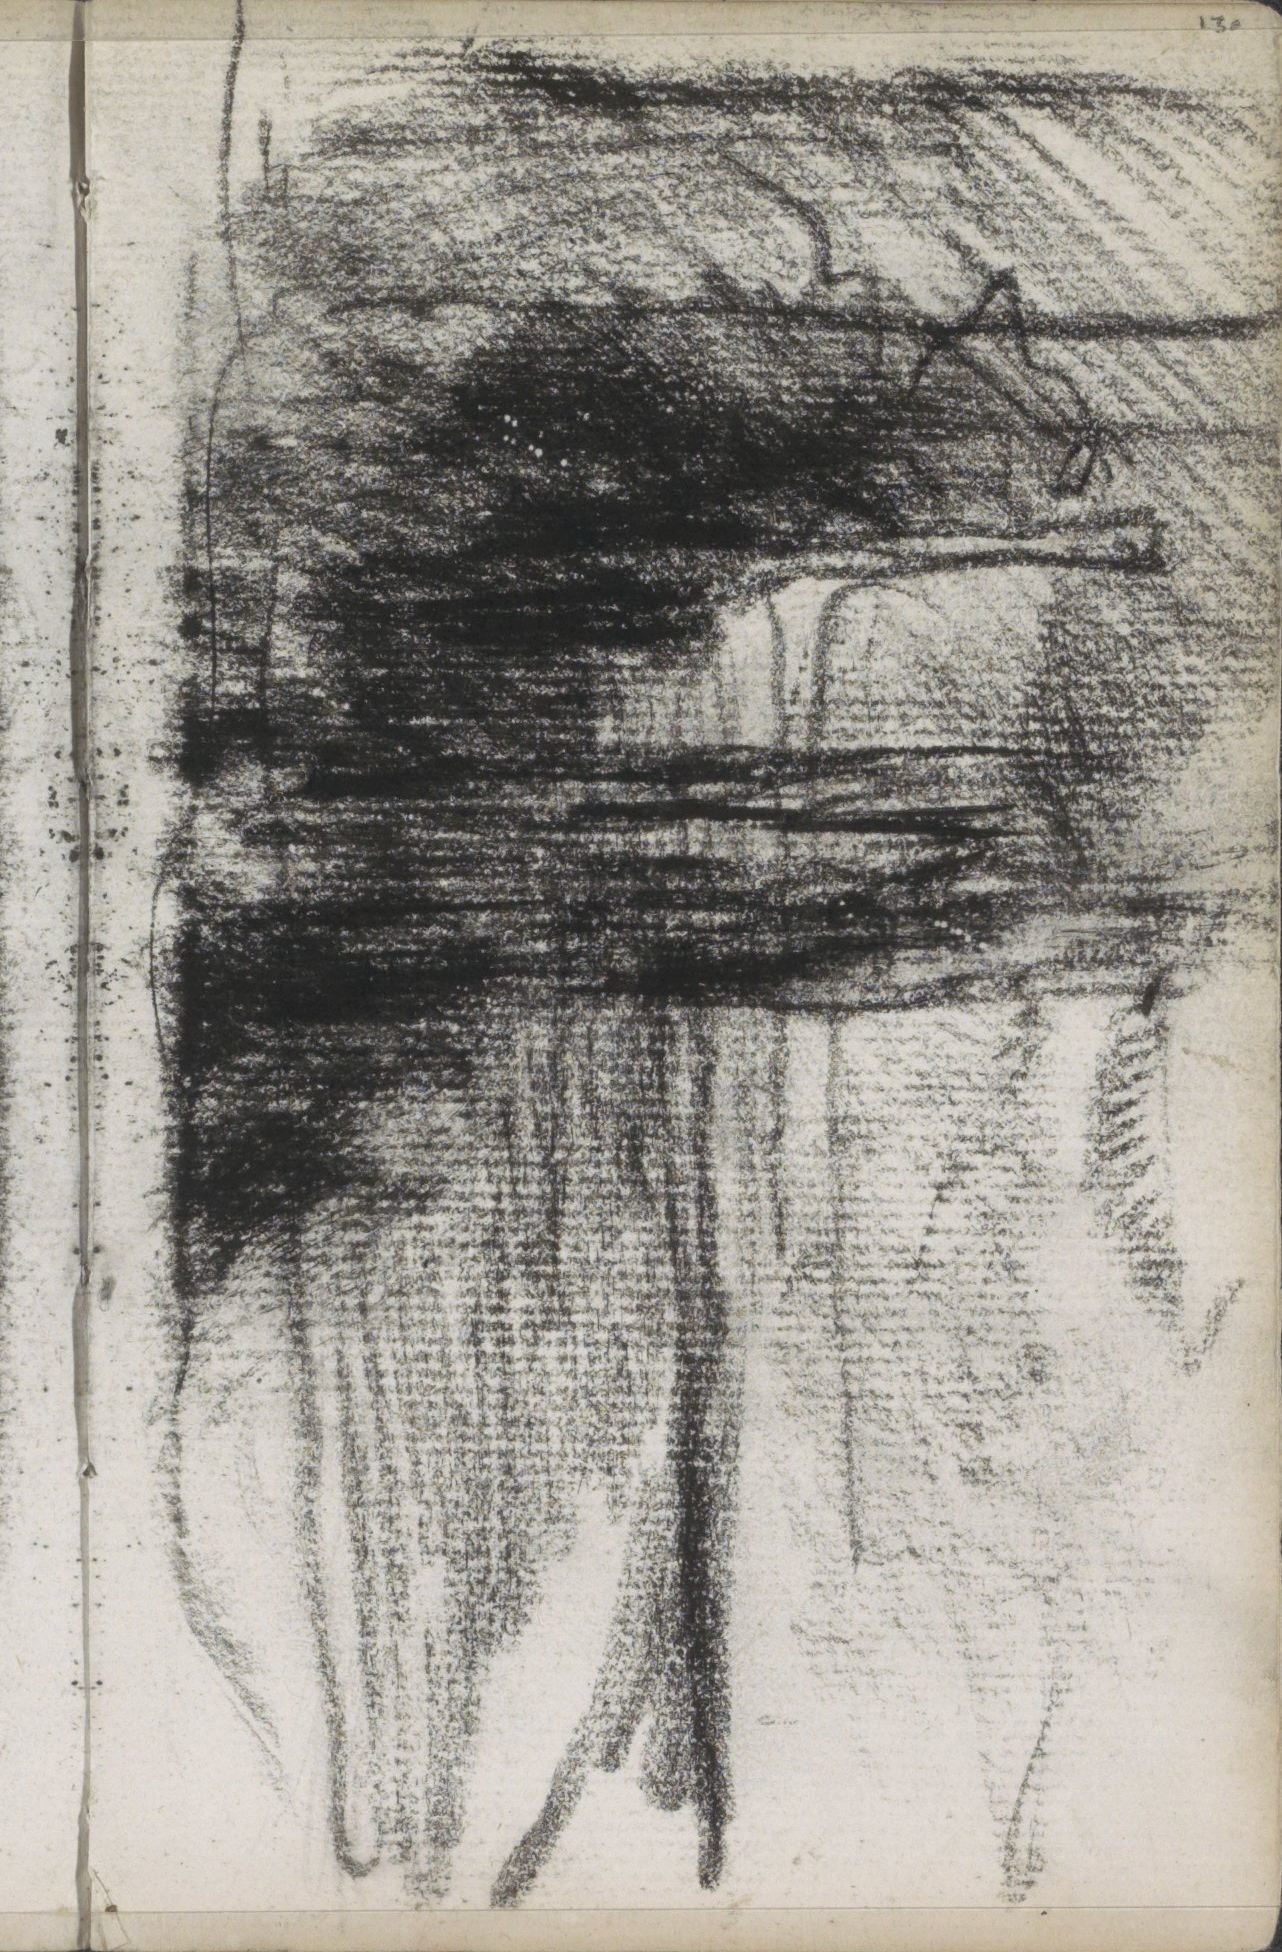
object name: sketchbook leaf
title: Studie, mogelijk van een gebouw in een landschap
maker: george hendrik breitner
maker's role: draughtsman, painter, print maker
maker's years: 1857-1923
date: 1884-1886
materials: chalk, paper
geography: drenthe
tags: landscapes, adult man, civic architecture; edifices; dwellings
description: In het gebouw mogelijk een figuur. Pagina 130 uit een schetsboek met 67 bladen vervaardigd in Drenthe.